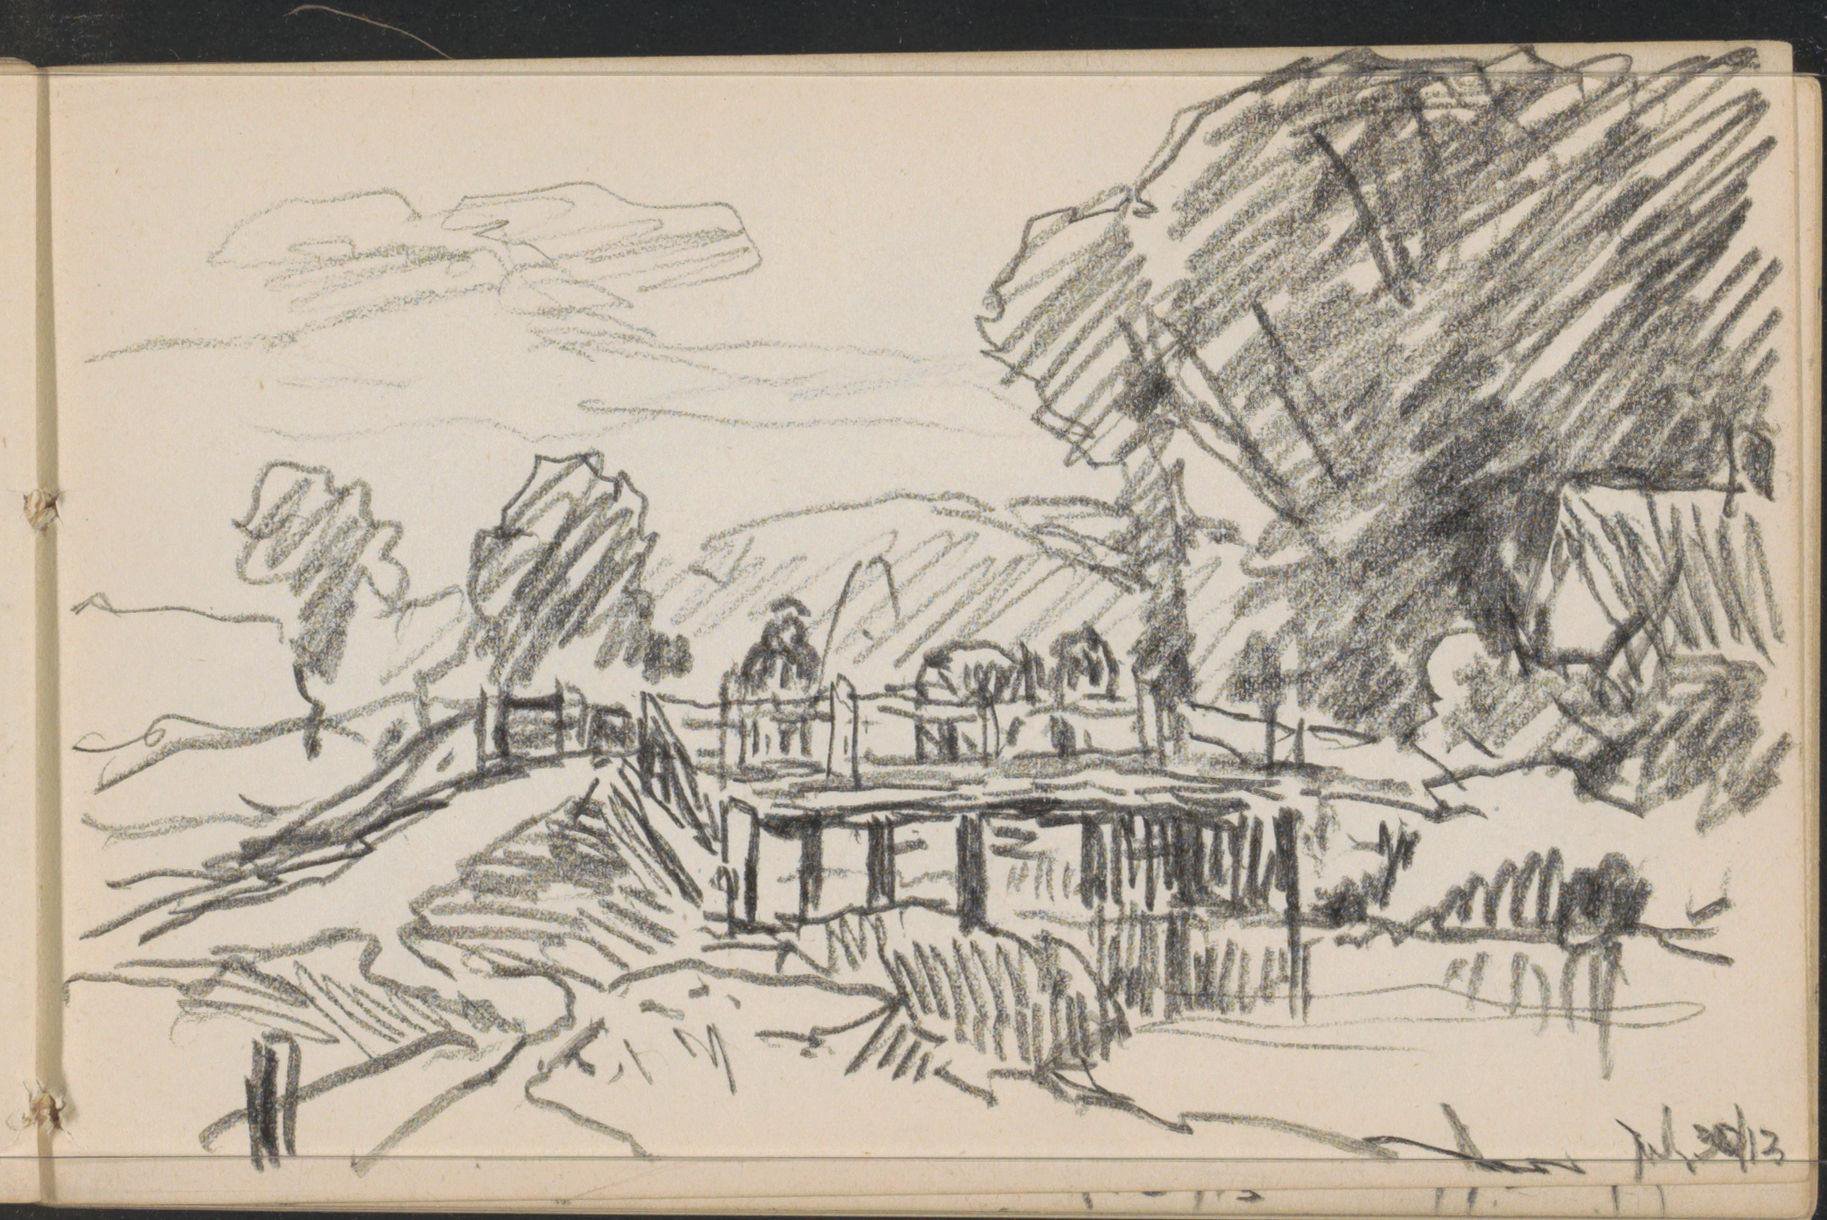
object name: sketchbook leaf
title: Figuur op een brug over een rivier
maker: alexander shilling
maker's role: draughtsman, print maker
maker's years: 1859-1937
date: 1907-1913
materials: chalk, paper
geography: dedham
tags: bridge, landscapes with waters, waterscapes, seascapes (in the temperate zone) (+ landscape with figures, staffage)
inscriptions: date: ‘Jul 30/13’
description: Mogelijk een brug bij Dedham. Blad 15 recto uit een schetsboek met 30 bladen.